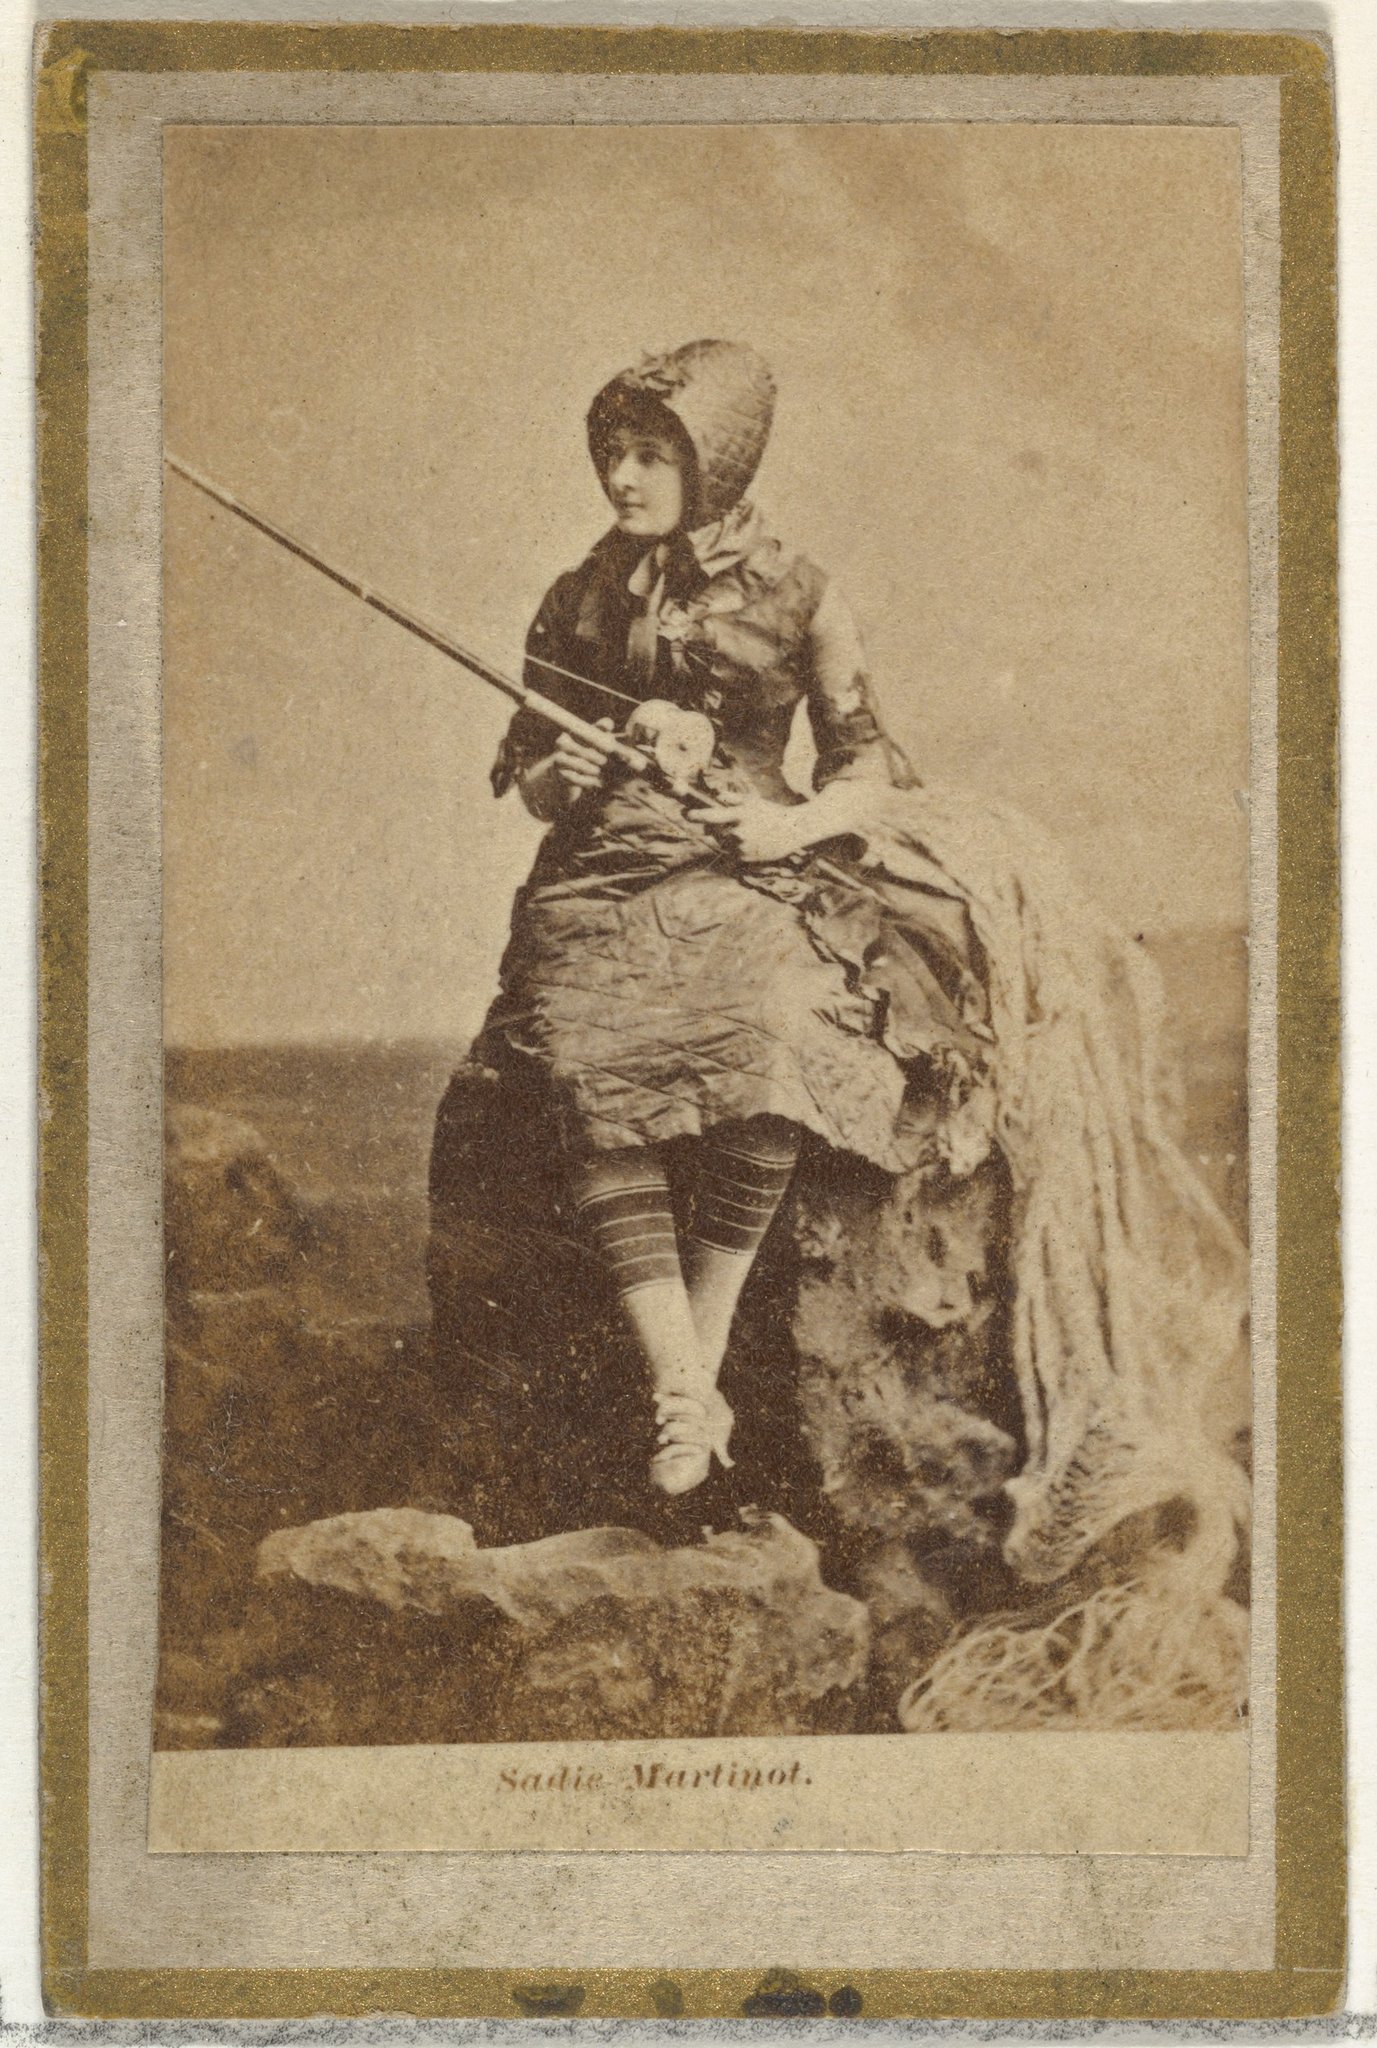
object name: photograph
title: Sadie Martinot, from the Actresses and Celebrities series (N60, Type 2) promoting Little Beauties Cigarettes for Allen & Ginter brand tobacco products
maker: allen & ginter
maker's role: publisher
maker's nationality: american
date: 1887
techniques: albumen silver print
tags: portraits,women,fishing,actresses